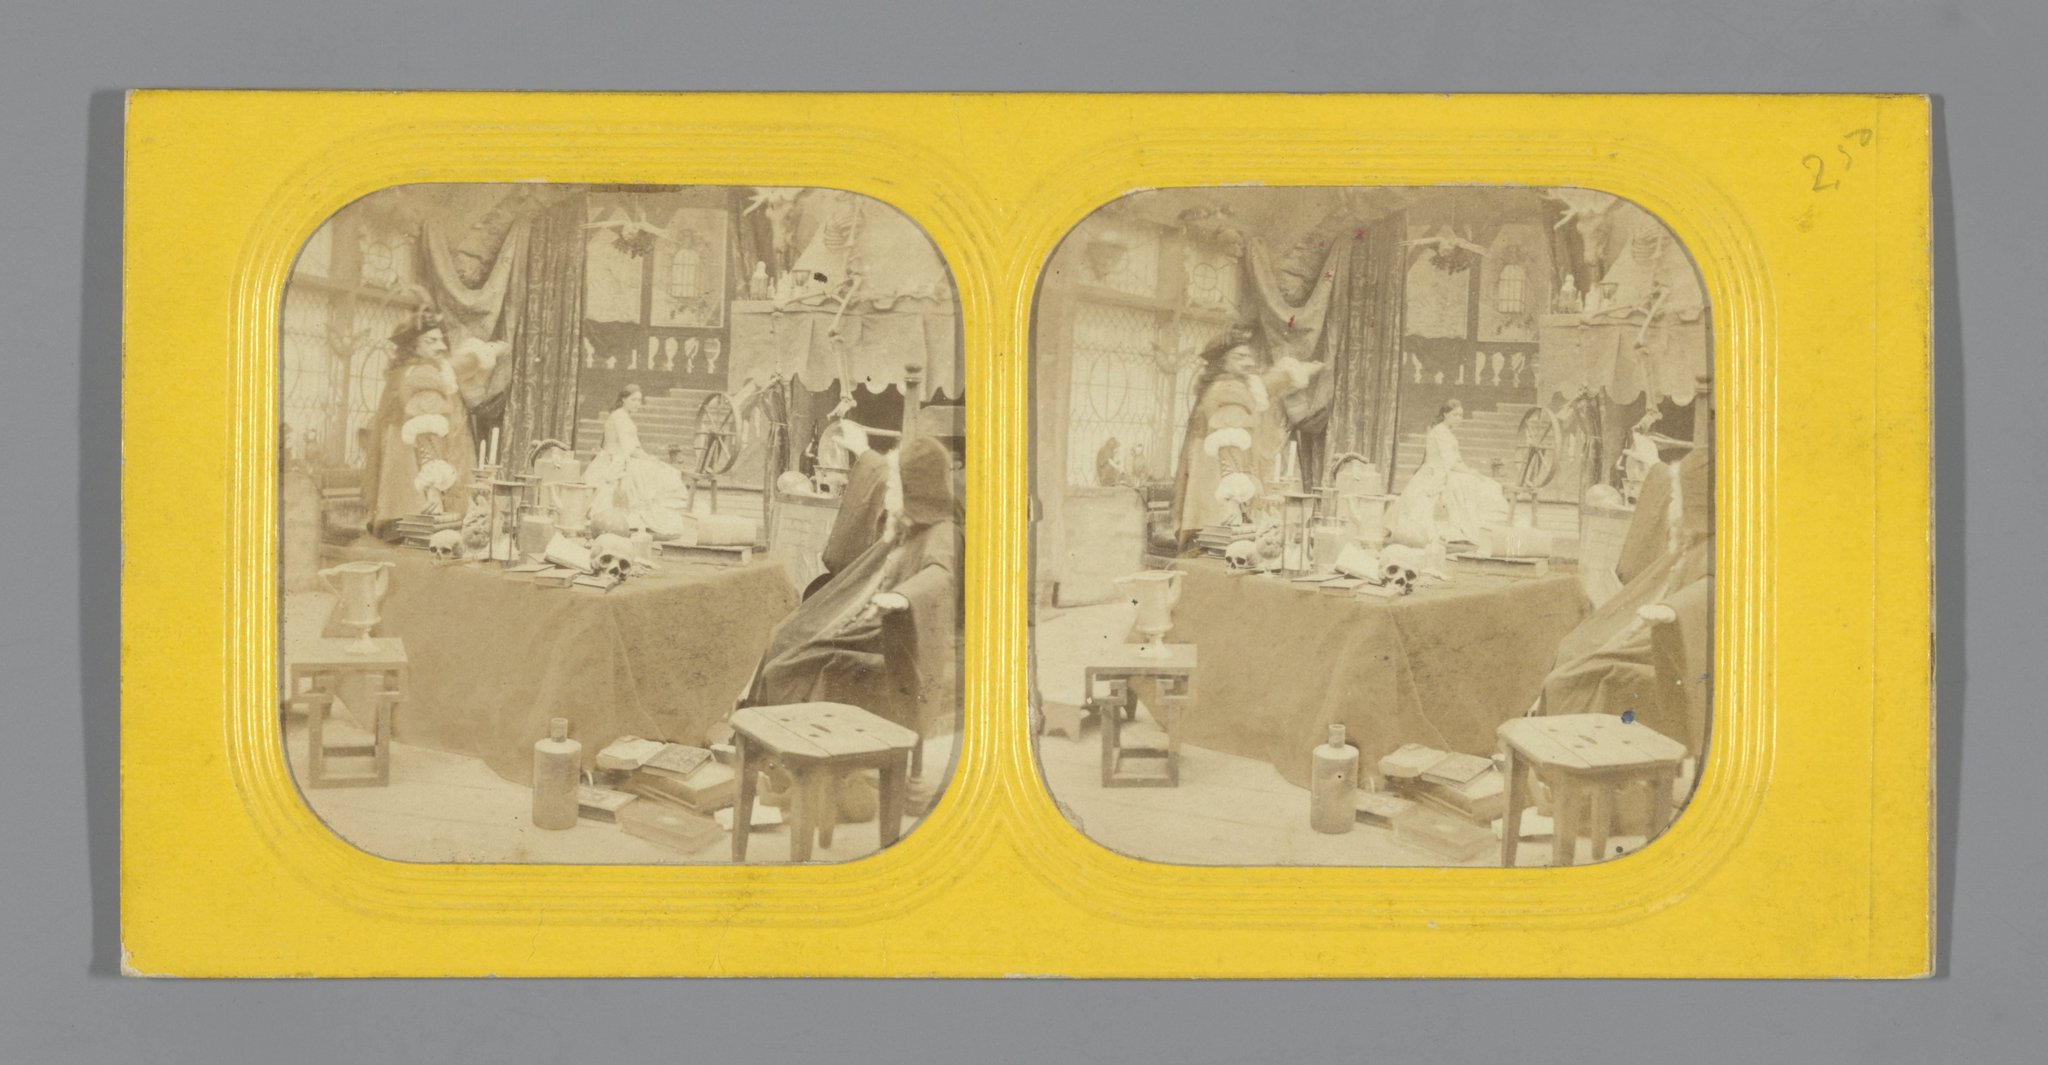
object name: tissue stereograph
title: Scène uit Faust: twee mensen wijzen een jonge vrouw de deur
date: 1868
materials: cardboard, paper, photographic support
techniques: albumen print, hand coloring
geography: paris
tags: castle - aa - civic architecture: inside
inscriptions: inscription: ‘2,50’